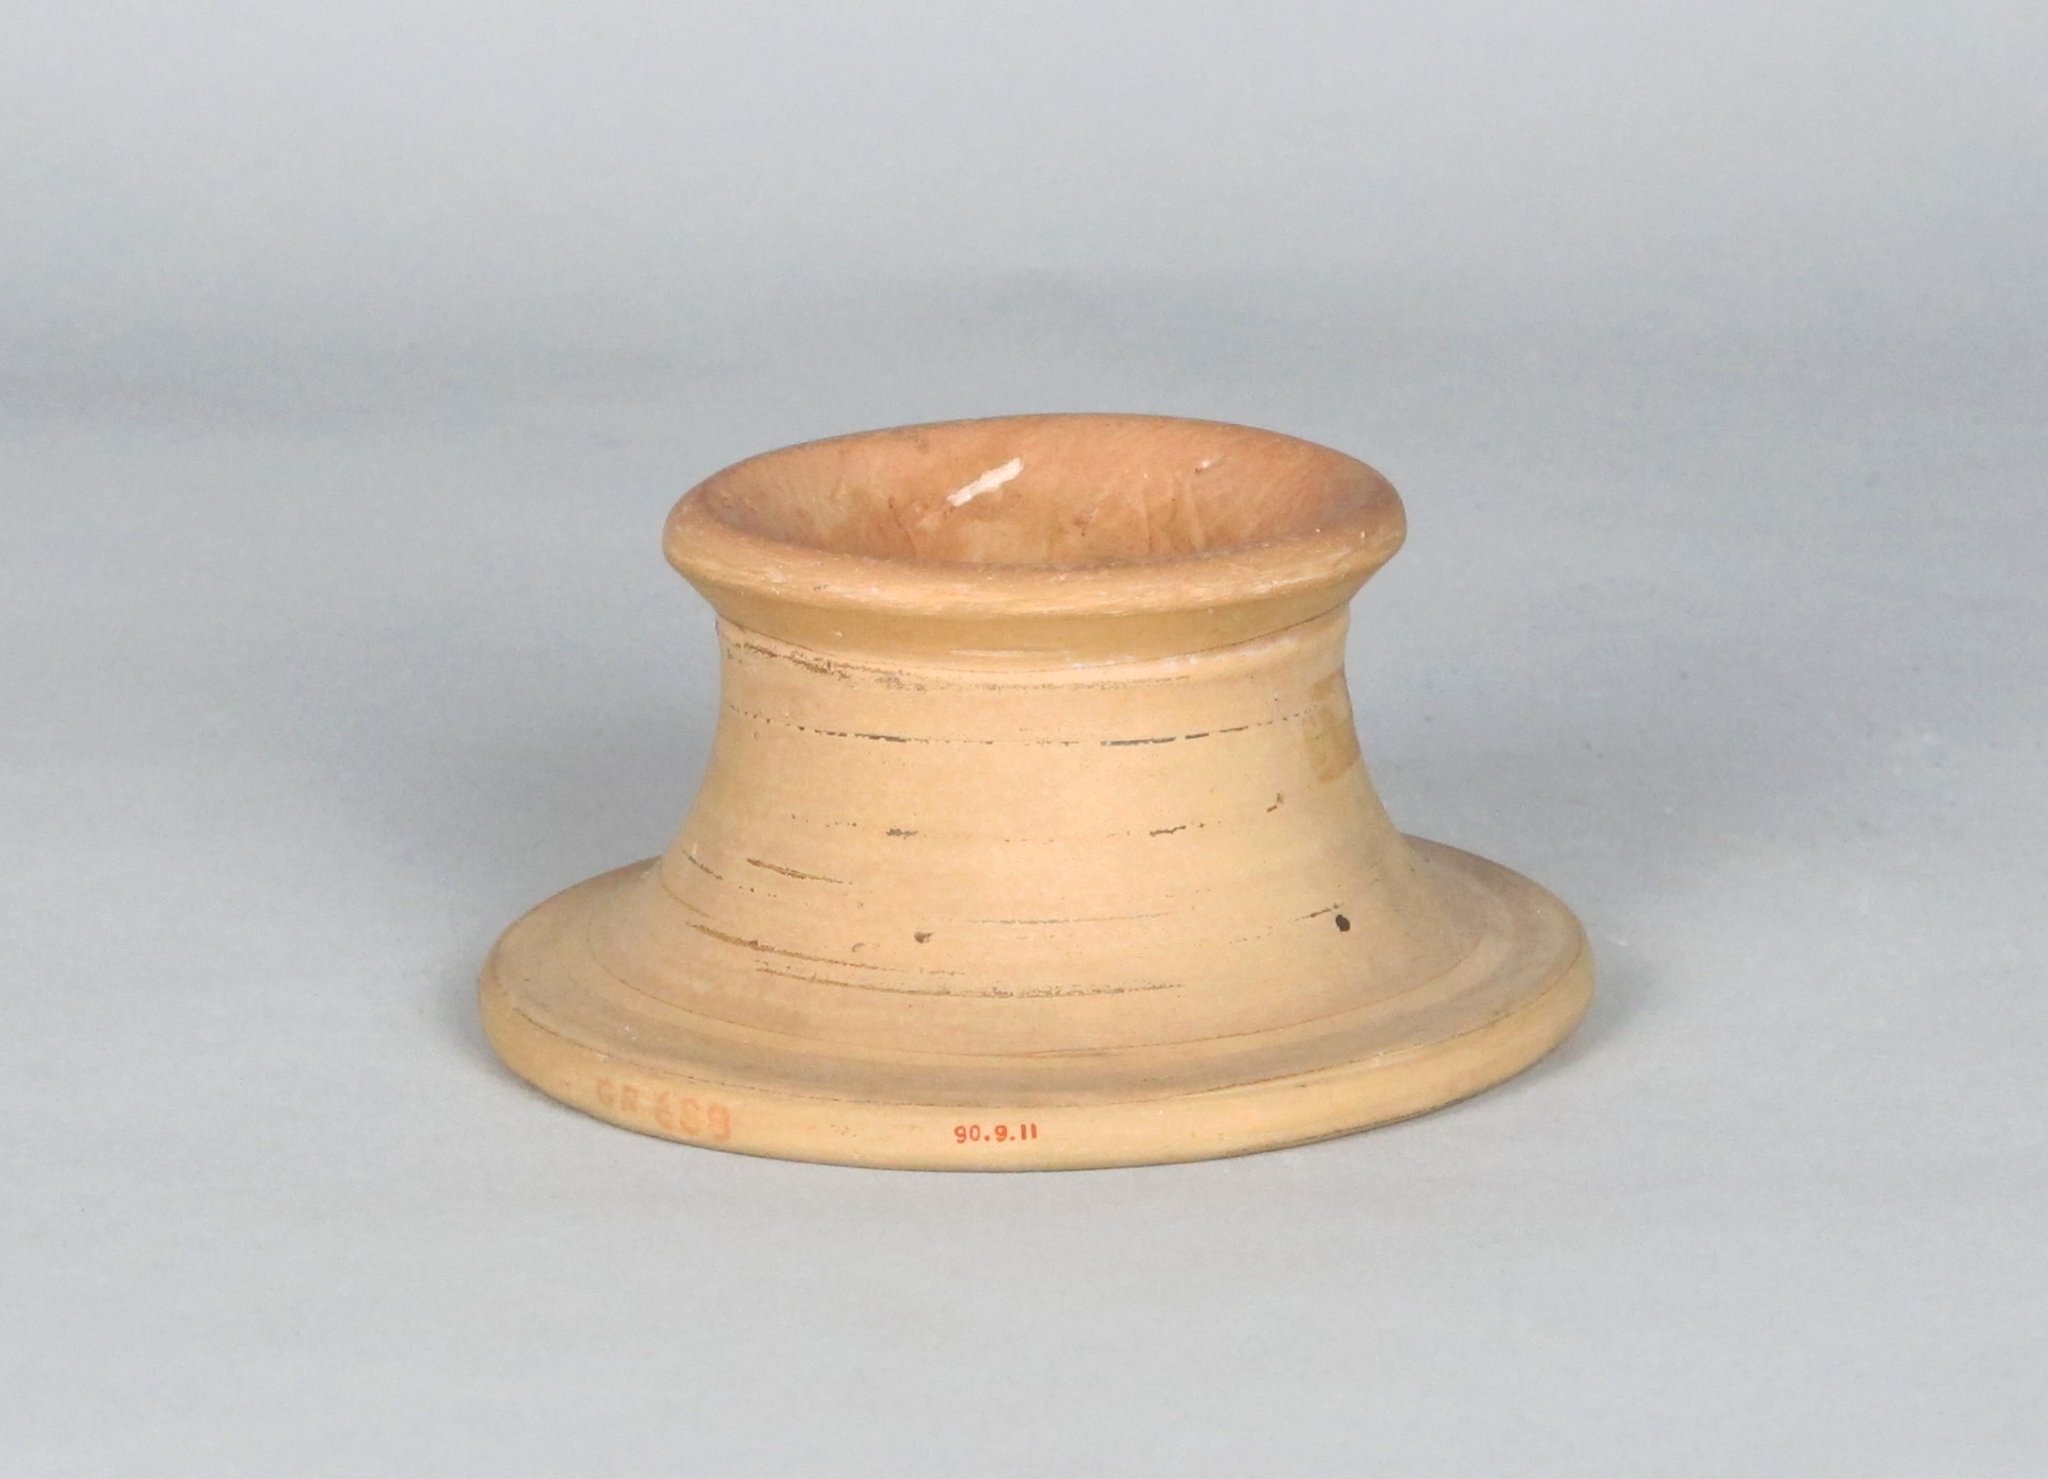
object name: hydria, hadra foot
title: Terracotta foot of Hadra hydria (water jar)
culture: greek, egyptian, alexandria-hadra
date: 323 BCE-31 CE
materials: terracotta